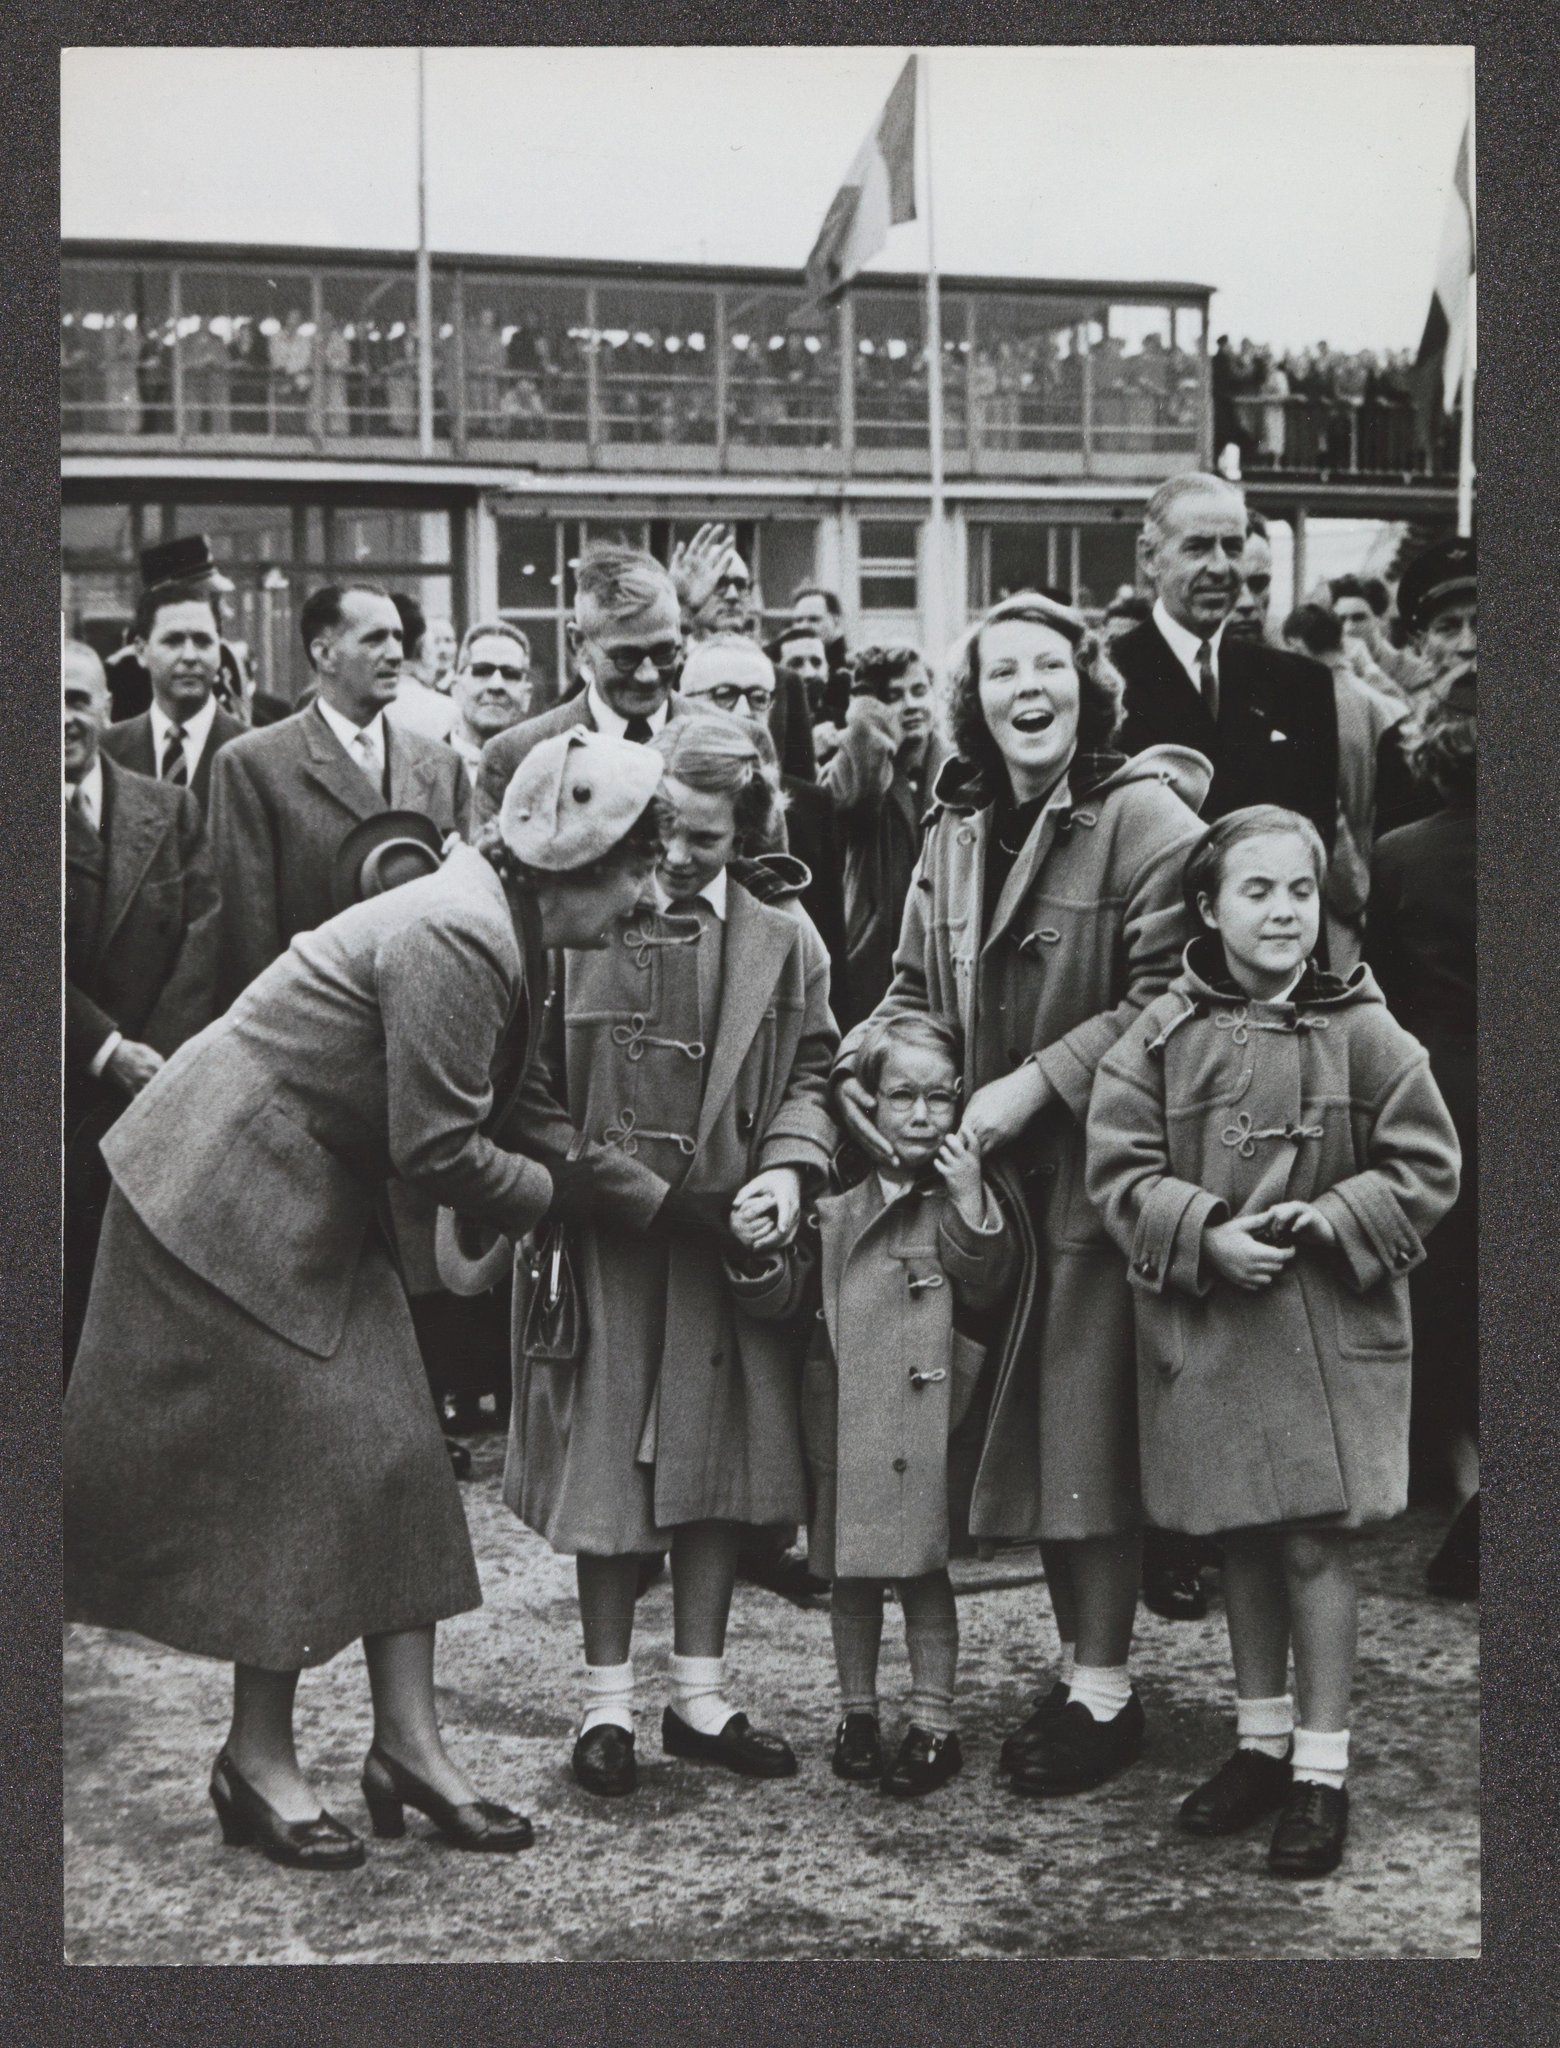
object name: photograph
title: Koningin Juliana en de vier prinsessen zwaaien hun vader uit op de luchthaven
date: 1952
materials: paper, photographic support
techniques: gelatin silver print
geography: netherlands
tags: the hague, beatrix (koningin der nederlanden), juliana of the netherlands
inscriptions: annotation: ‘Eine weinende Prinsessin Marijke wird durch ihra Mutter end den anderen Prinzessinnen getrostet’